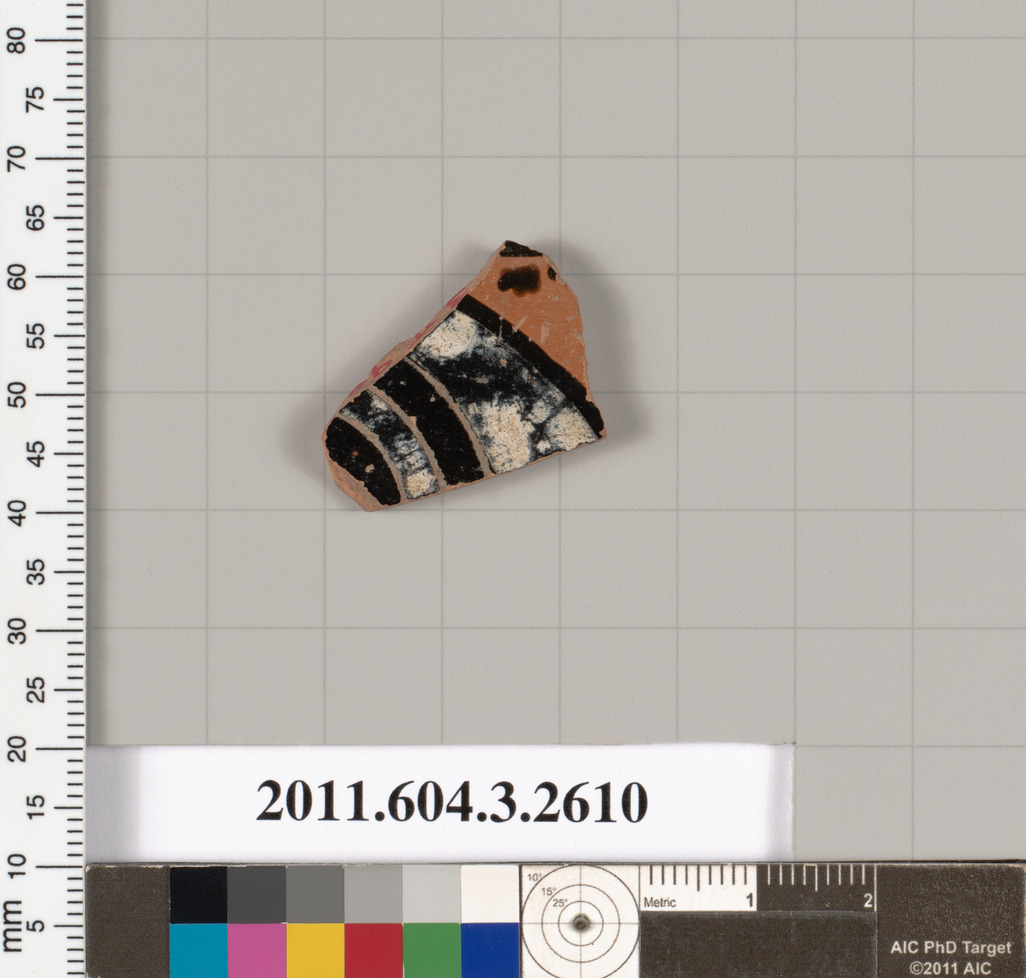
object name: kylix fragment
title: Terracotta fragment of a kylix (drinking cup)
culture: greek, attic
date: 530-510 BCE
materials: terracotta